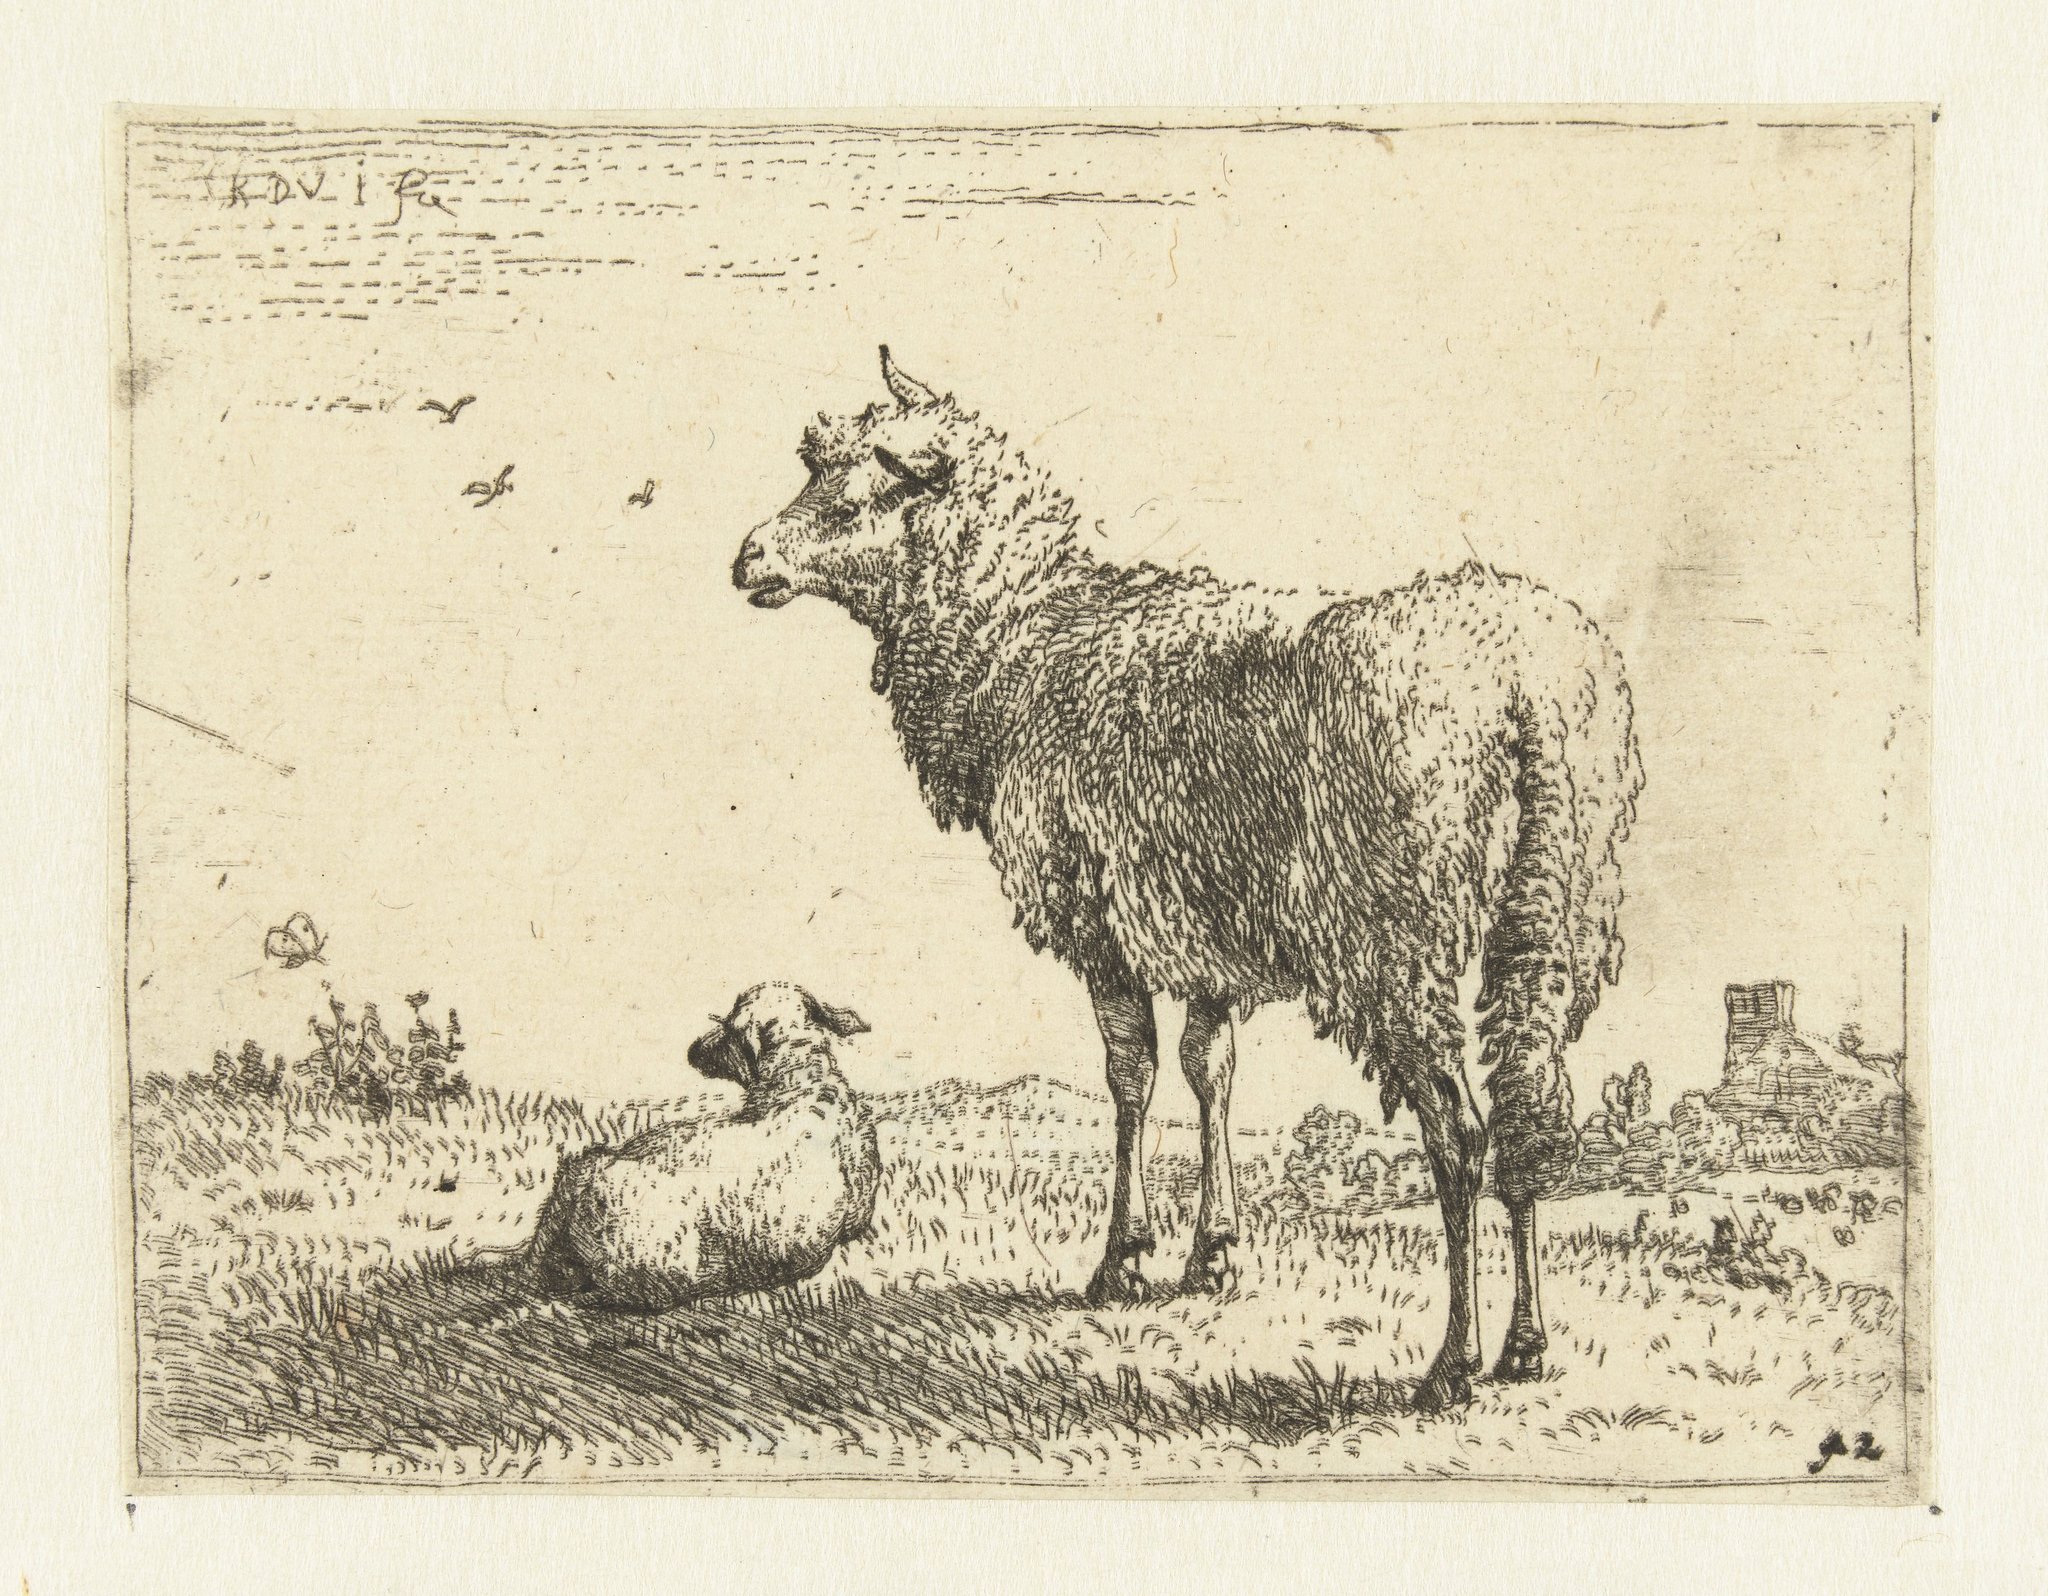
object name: print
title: Ooi met een lam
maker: karel du jardin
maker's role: draughtsman, painter, print maker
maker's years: 1626-1678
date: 1652-1659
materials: paper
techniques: etching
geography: netherlands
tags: lamb, ewe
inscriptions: collector's mark: Lugt 2228a